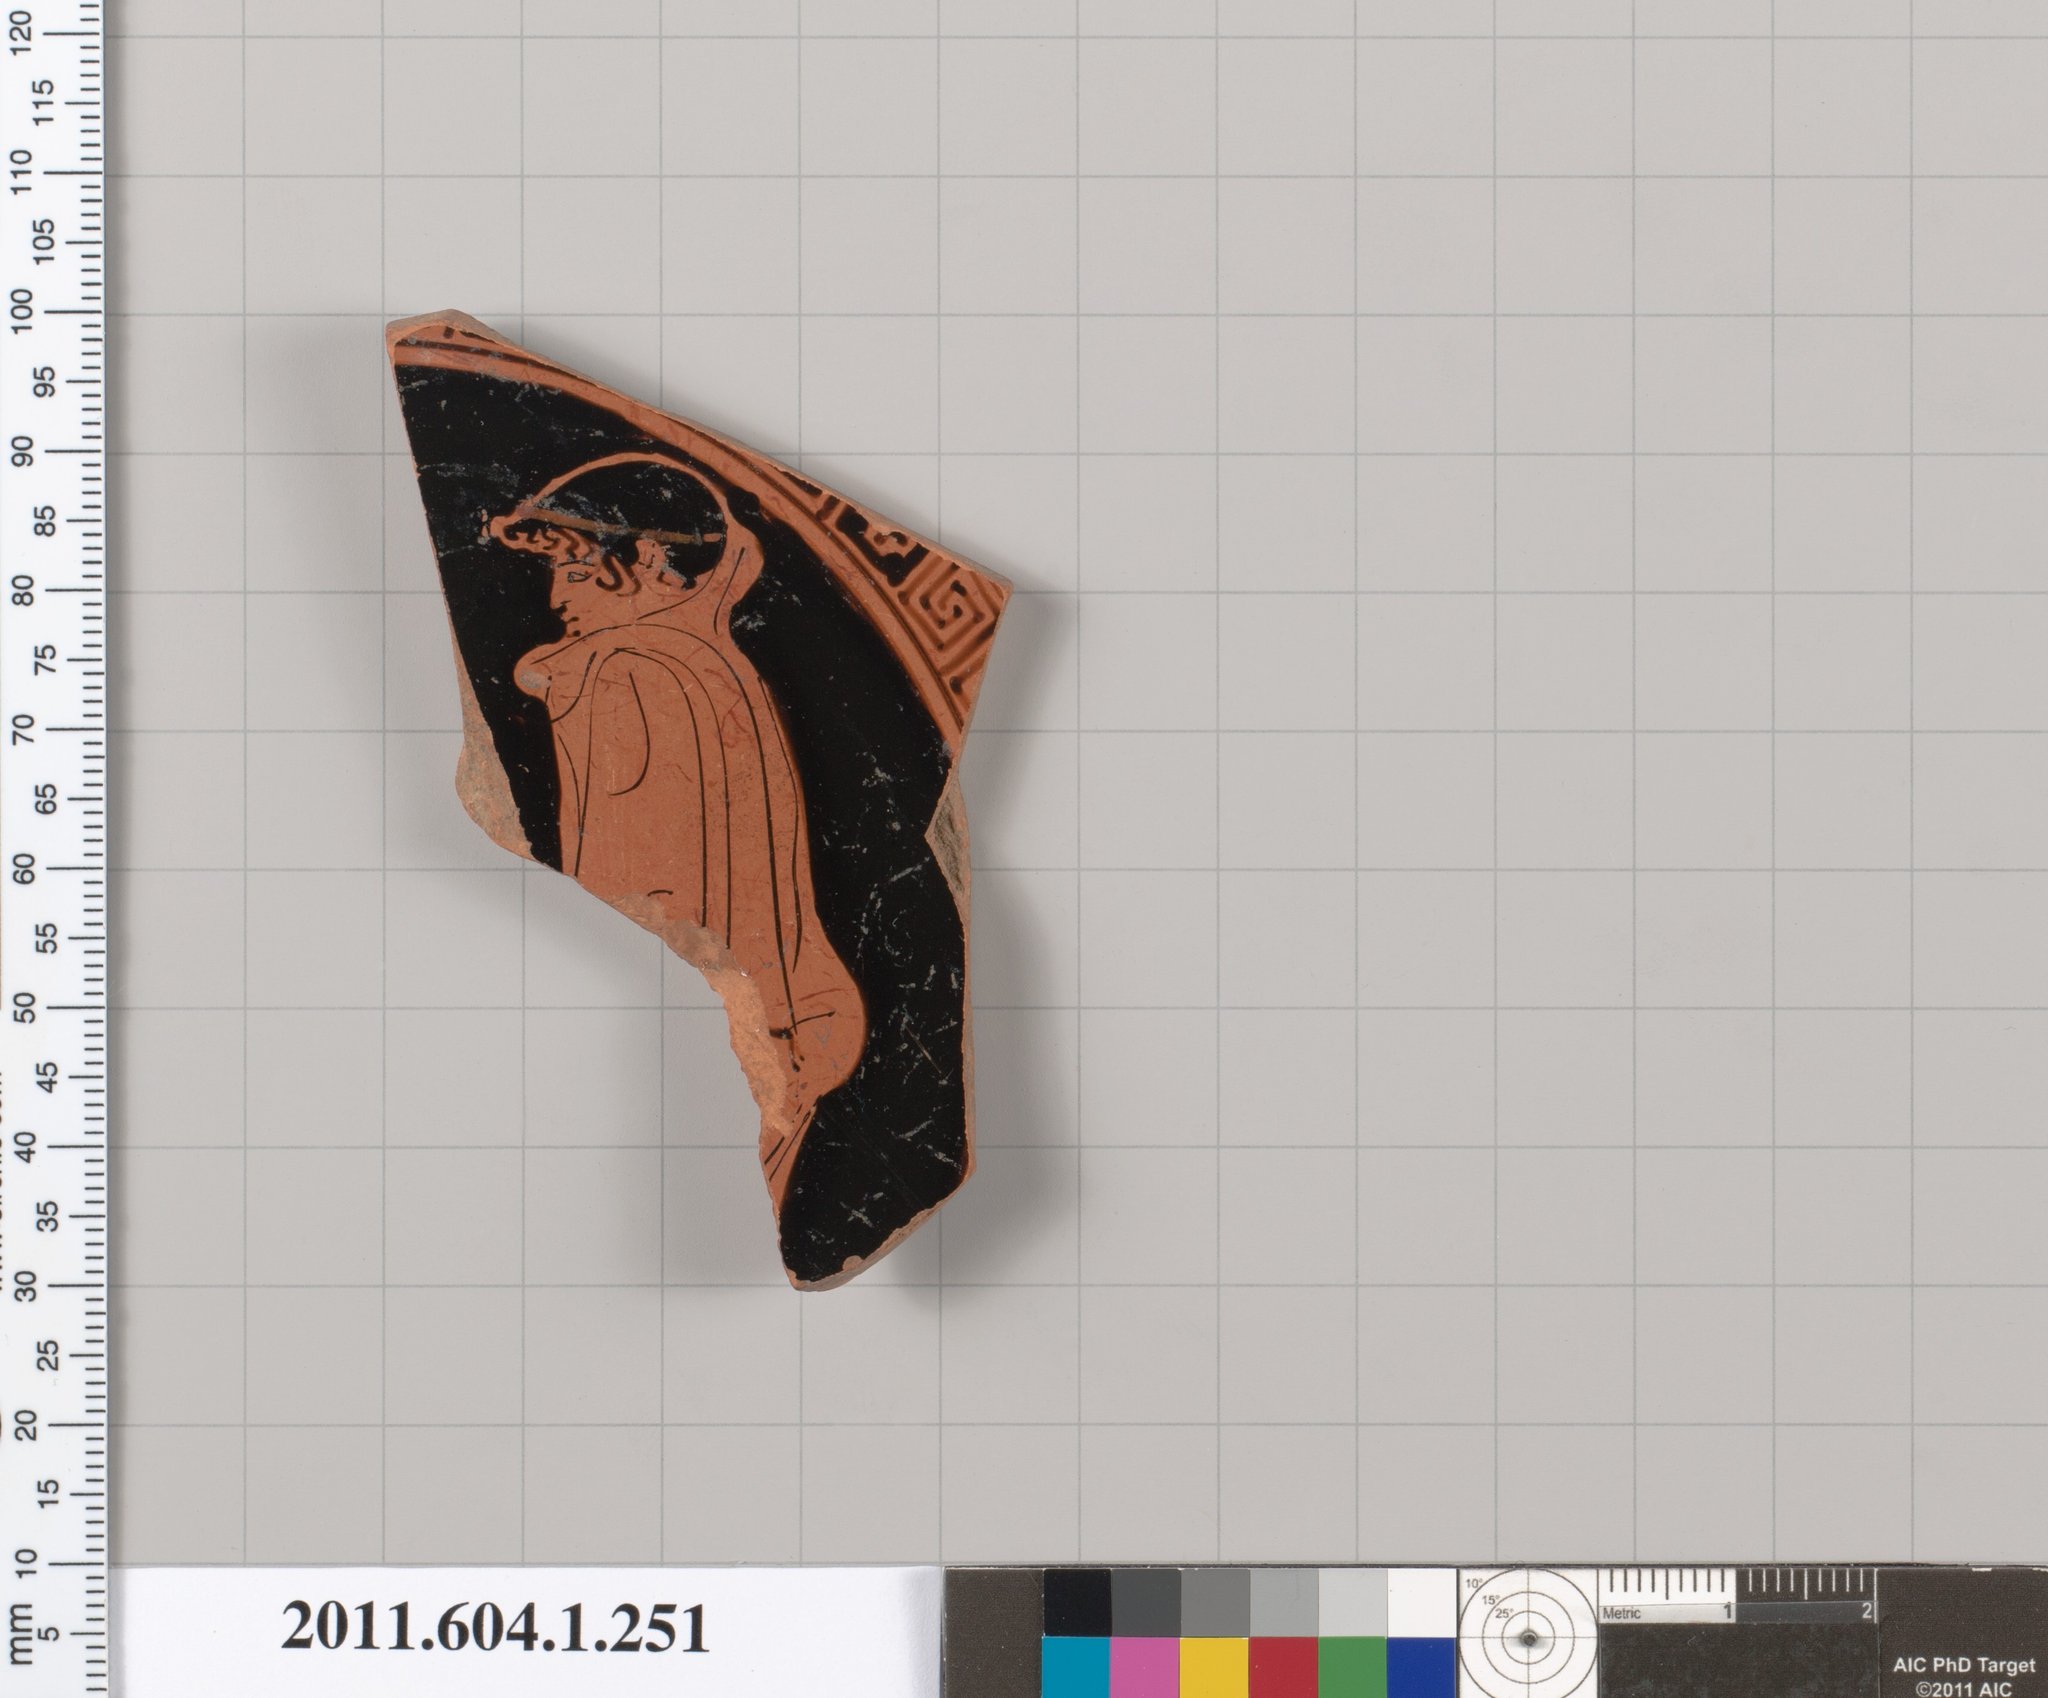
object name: kylix fragment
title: Terracotta fragment of a kylix (drinking cup)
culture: greek, attic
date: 475-451 BCE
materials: terracotta